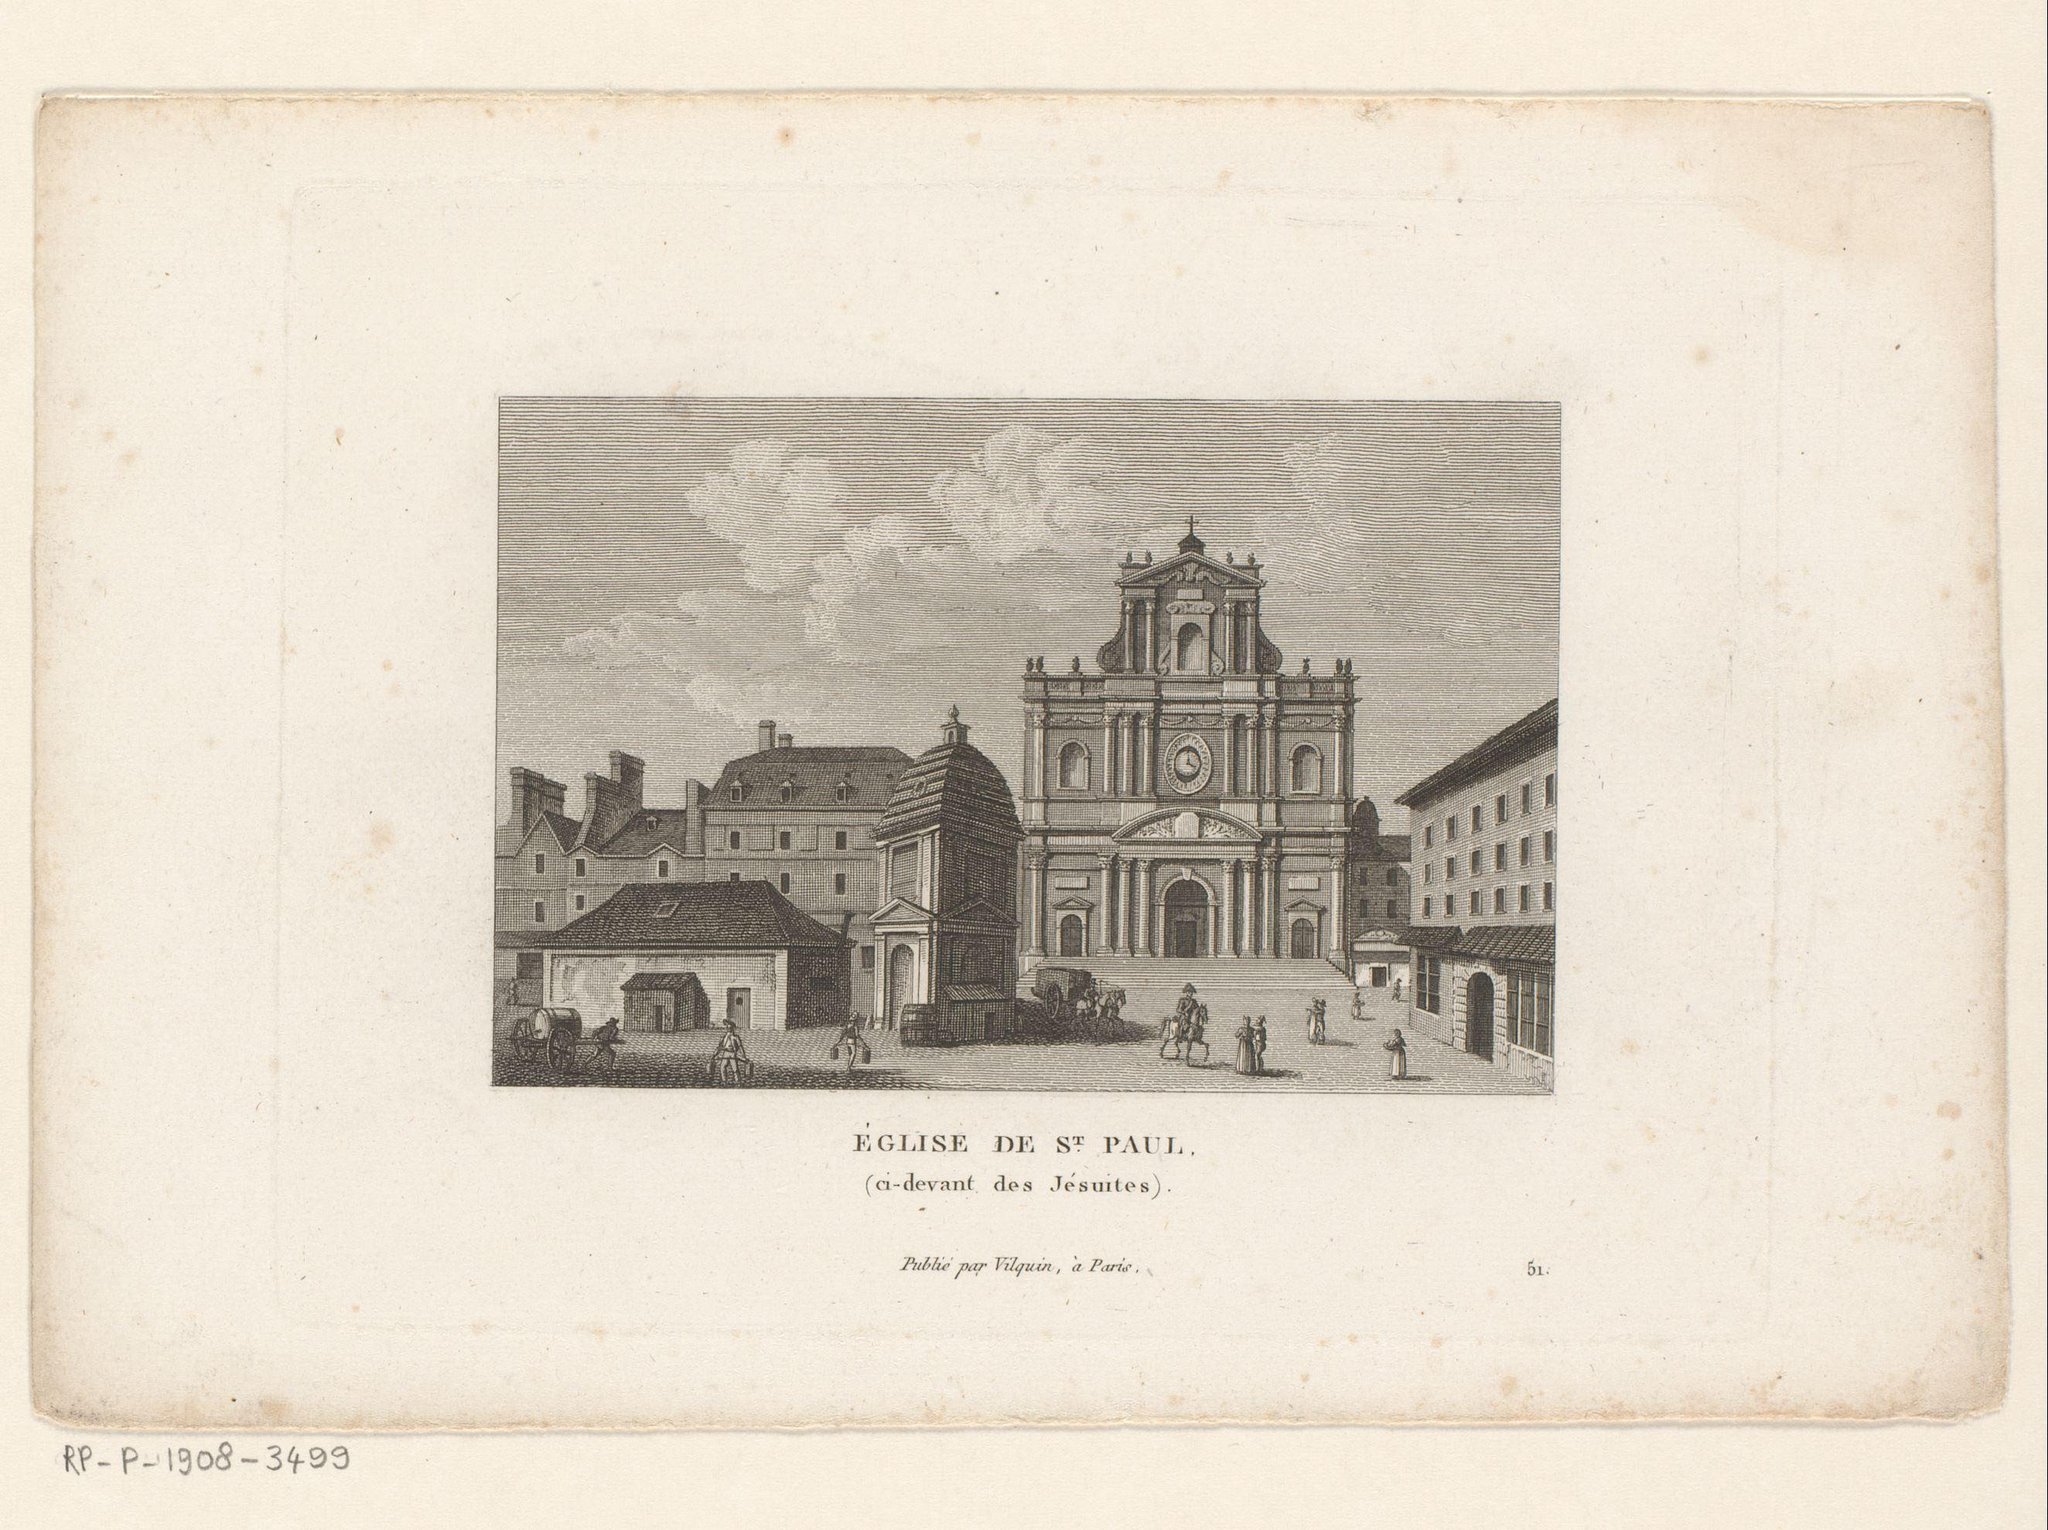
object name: print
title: Gezicht op de Église Saint-Paul-Saint-Louis te Parijs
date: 1818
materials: paper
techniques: etching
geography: paris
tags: city-view in general; 'veduta', paris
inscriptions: collector's mark: Lugt 2228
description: Maakt deel uit van een serie met 60 platen van monumenten, kathedralen en paleizen in Parijs.